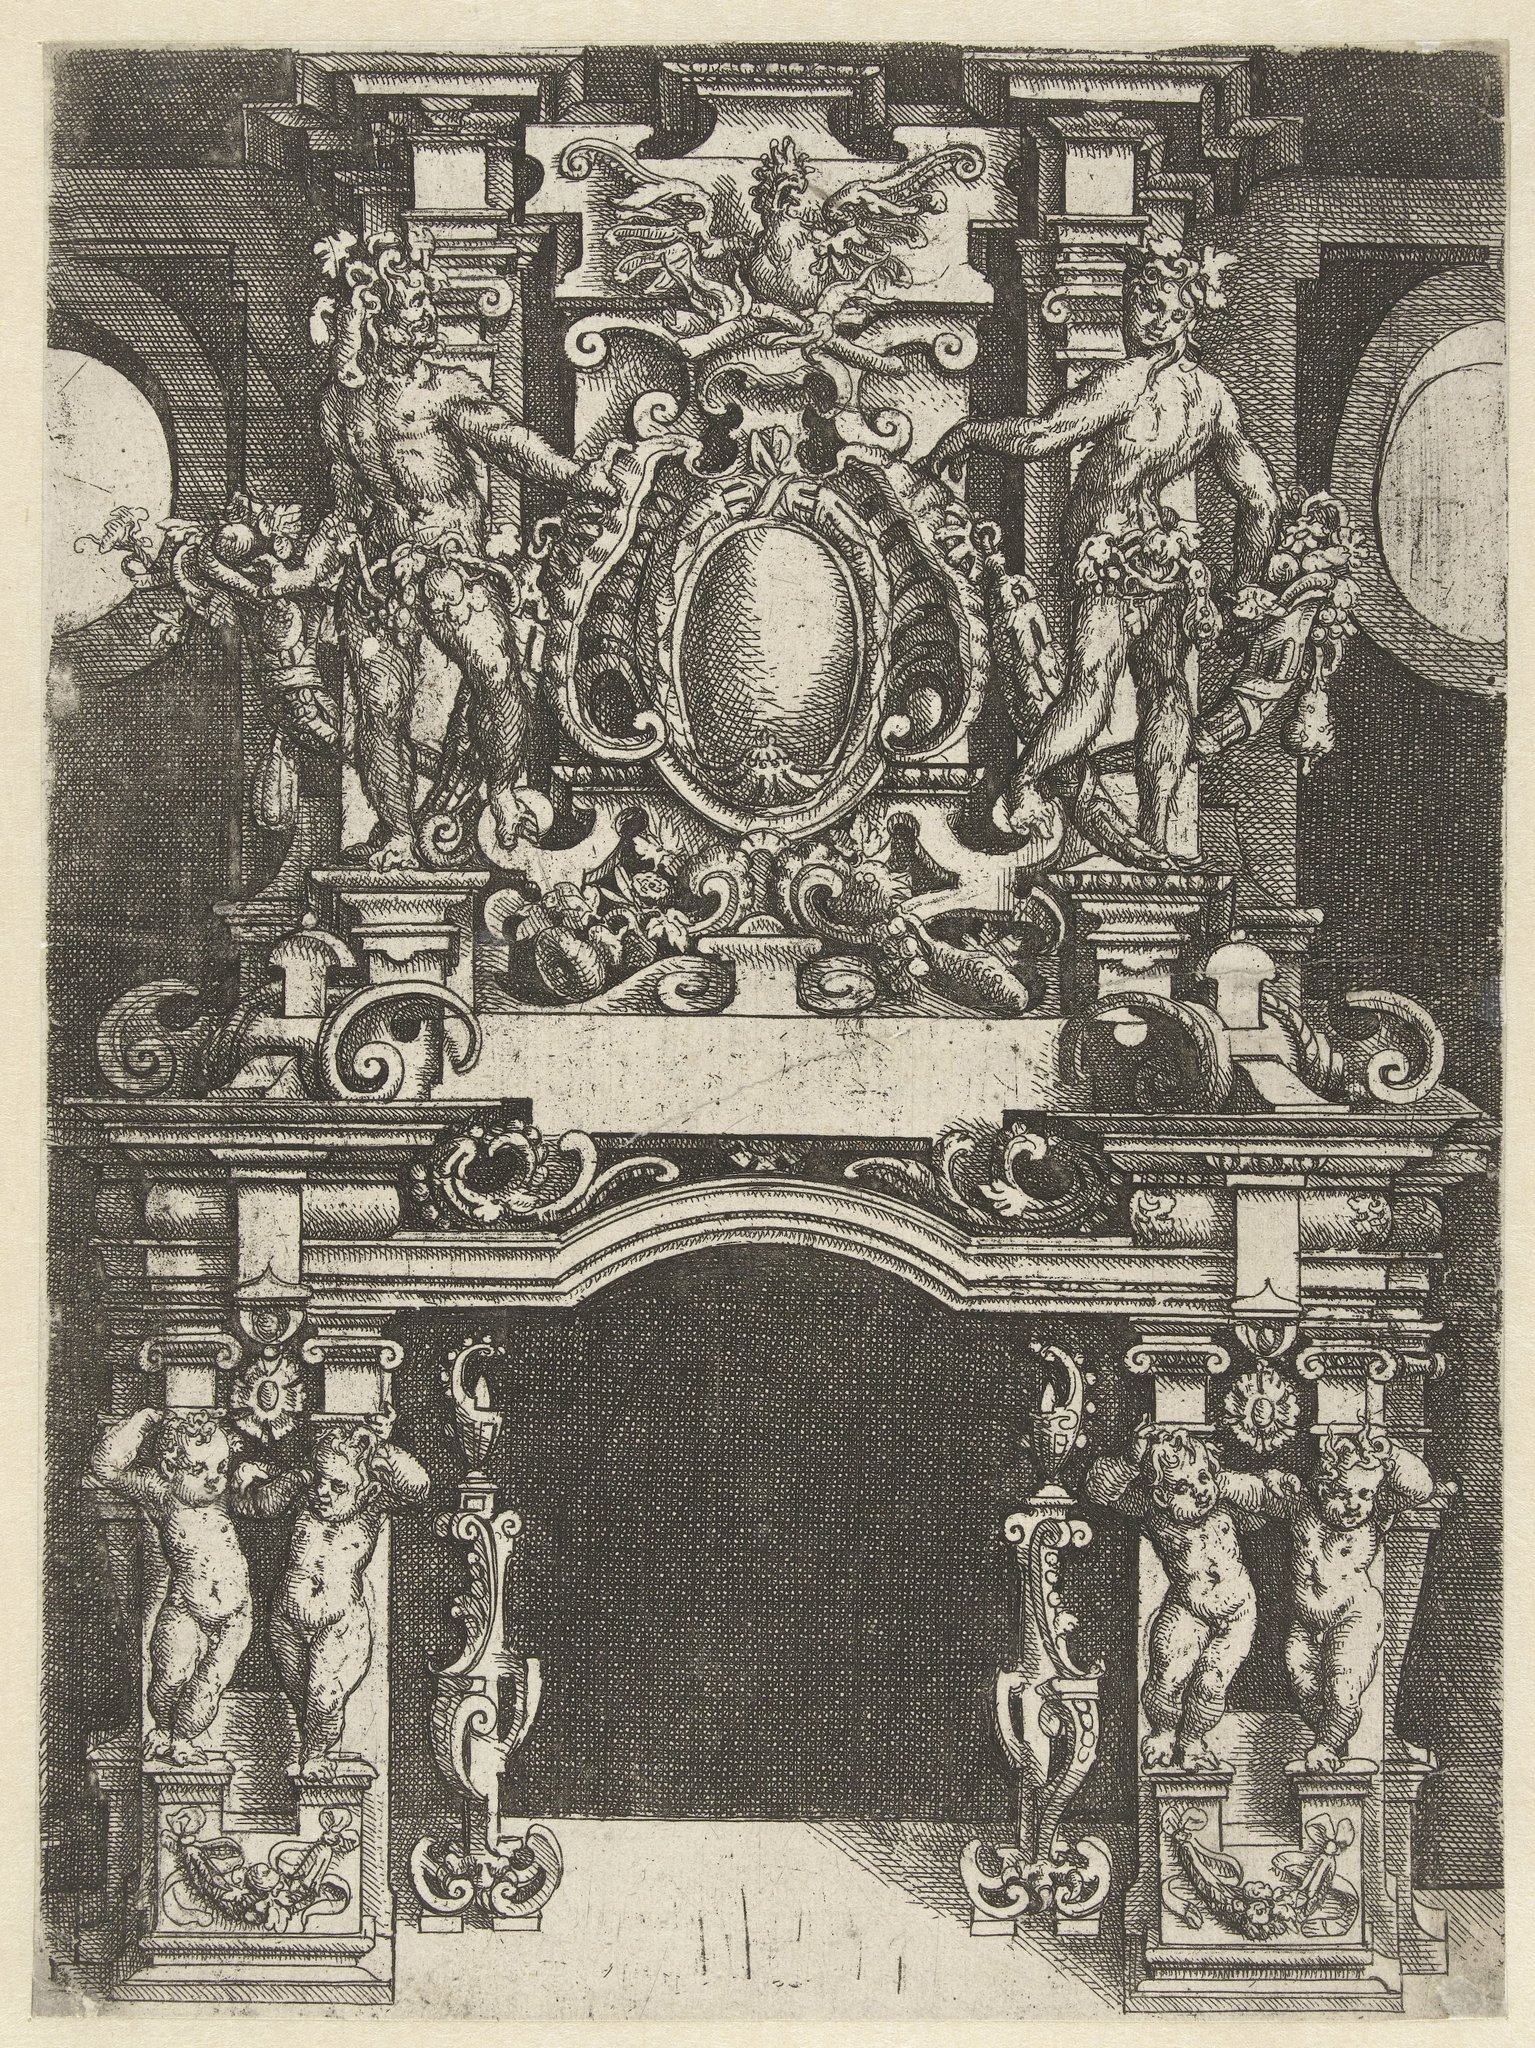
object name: print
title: Blad uit de Architecture, 2e uitg. v. 1598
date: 1560-1598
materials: paper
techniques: etching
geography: germany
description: Links en rechts onderaan staan telkens twee putti die als kariatiden de mantel dragen. 1 van 20 bladen uit een serie (Architectura. Von Ausztheilung, Symmetria und Proportion der fünff Seulen...) bestaande uit 193 bladen en 5 titelbladen, verdeeld over vijf boeken. Het gaat hier om een tweede, uitgebreide editie van de onder Orn Cat I-319 beschreven serie.